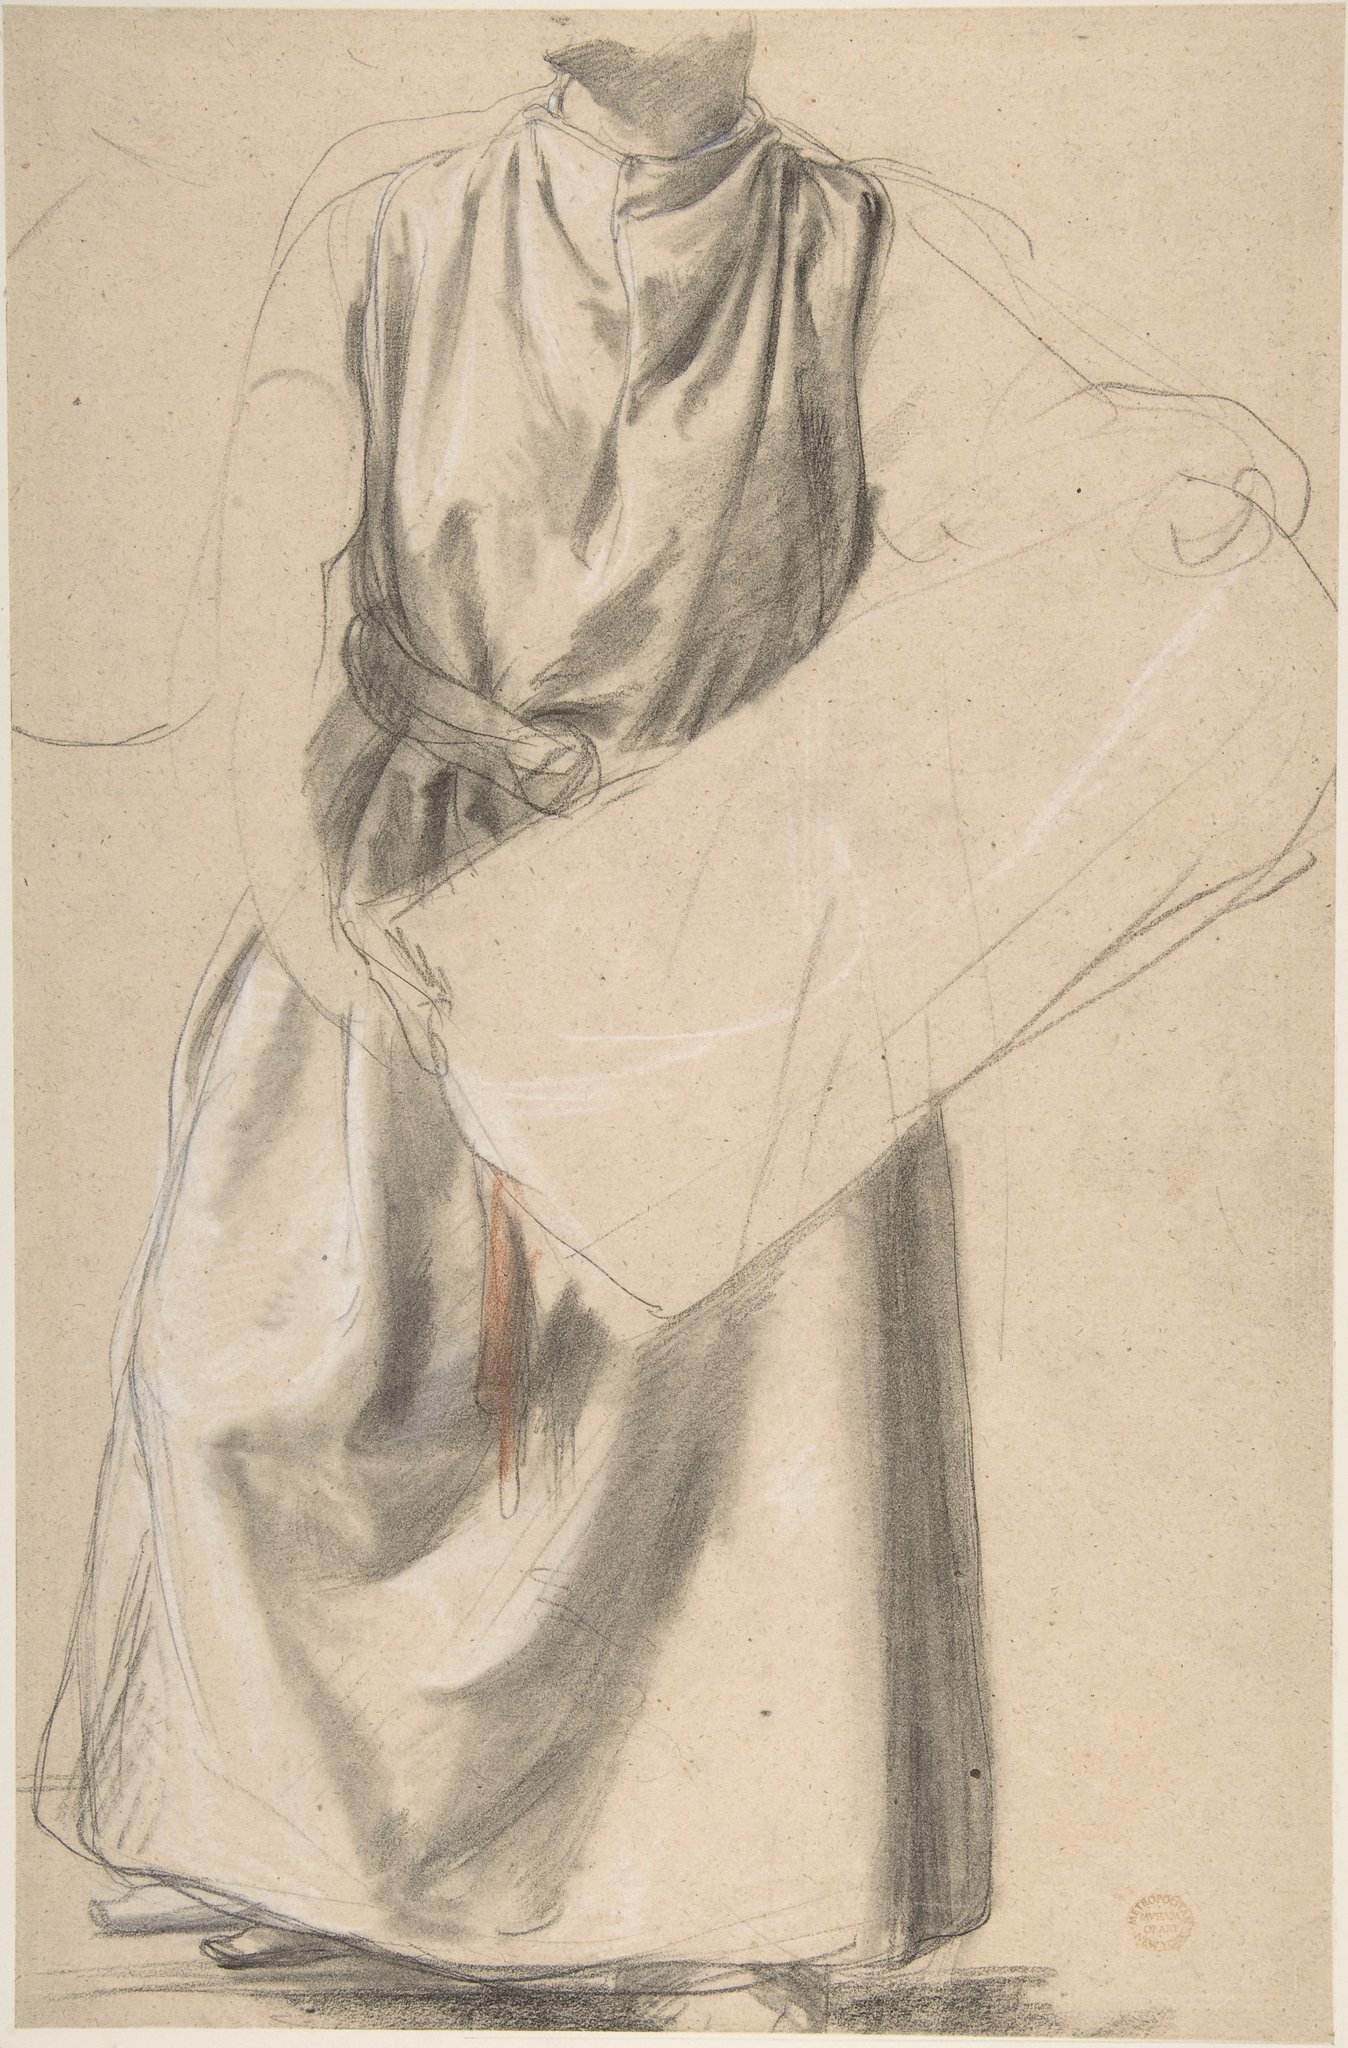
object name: drawing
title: Study of a Standing Figure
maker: romain cazes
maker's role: artist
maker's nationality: french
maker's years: 1808-1881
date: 1828-1881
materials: chalk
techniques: highlighting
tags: human figures